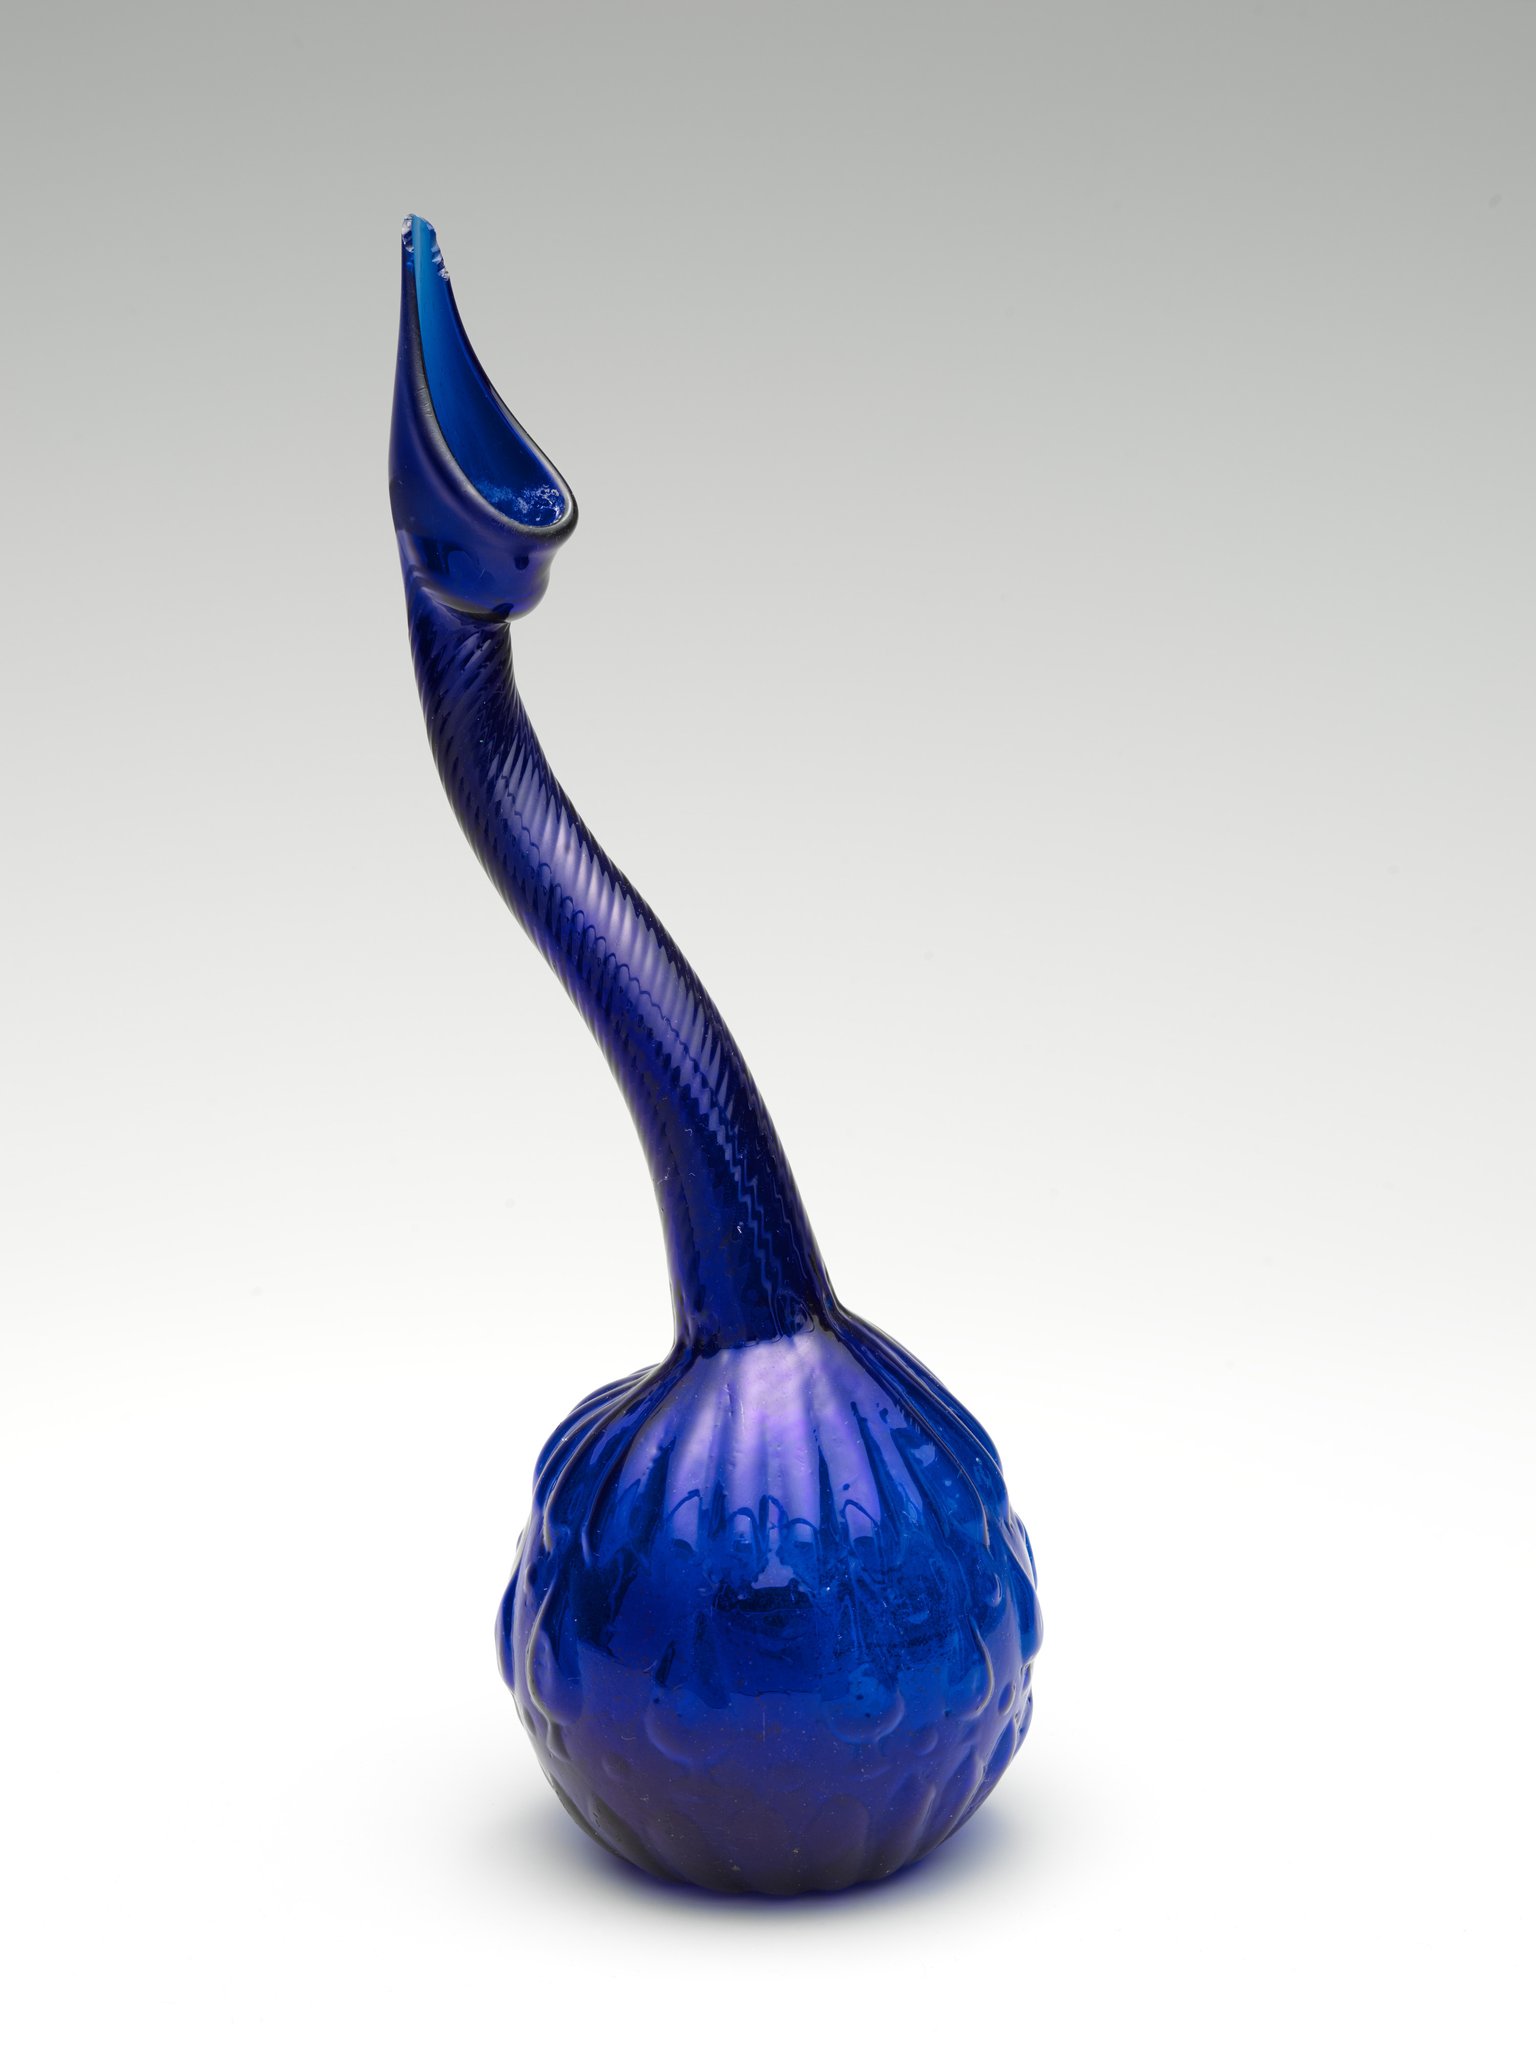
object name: bottle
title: Swan-Neck Bottle (Ashkdan)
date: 1701-1900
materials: glass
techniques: glassblowing, tooling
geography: iran